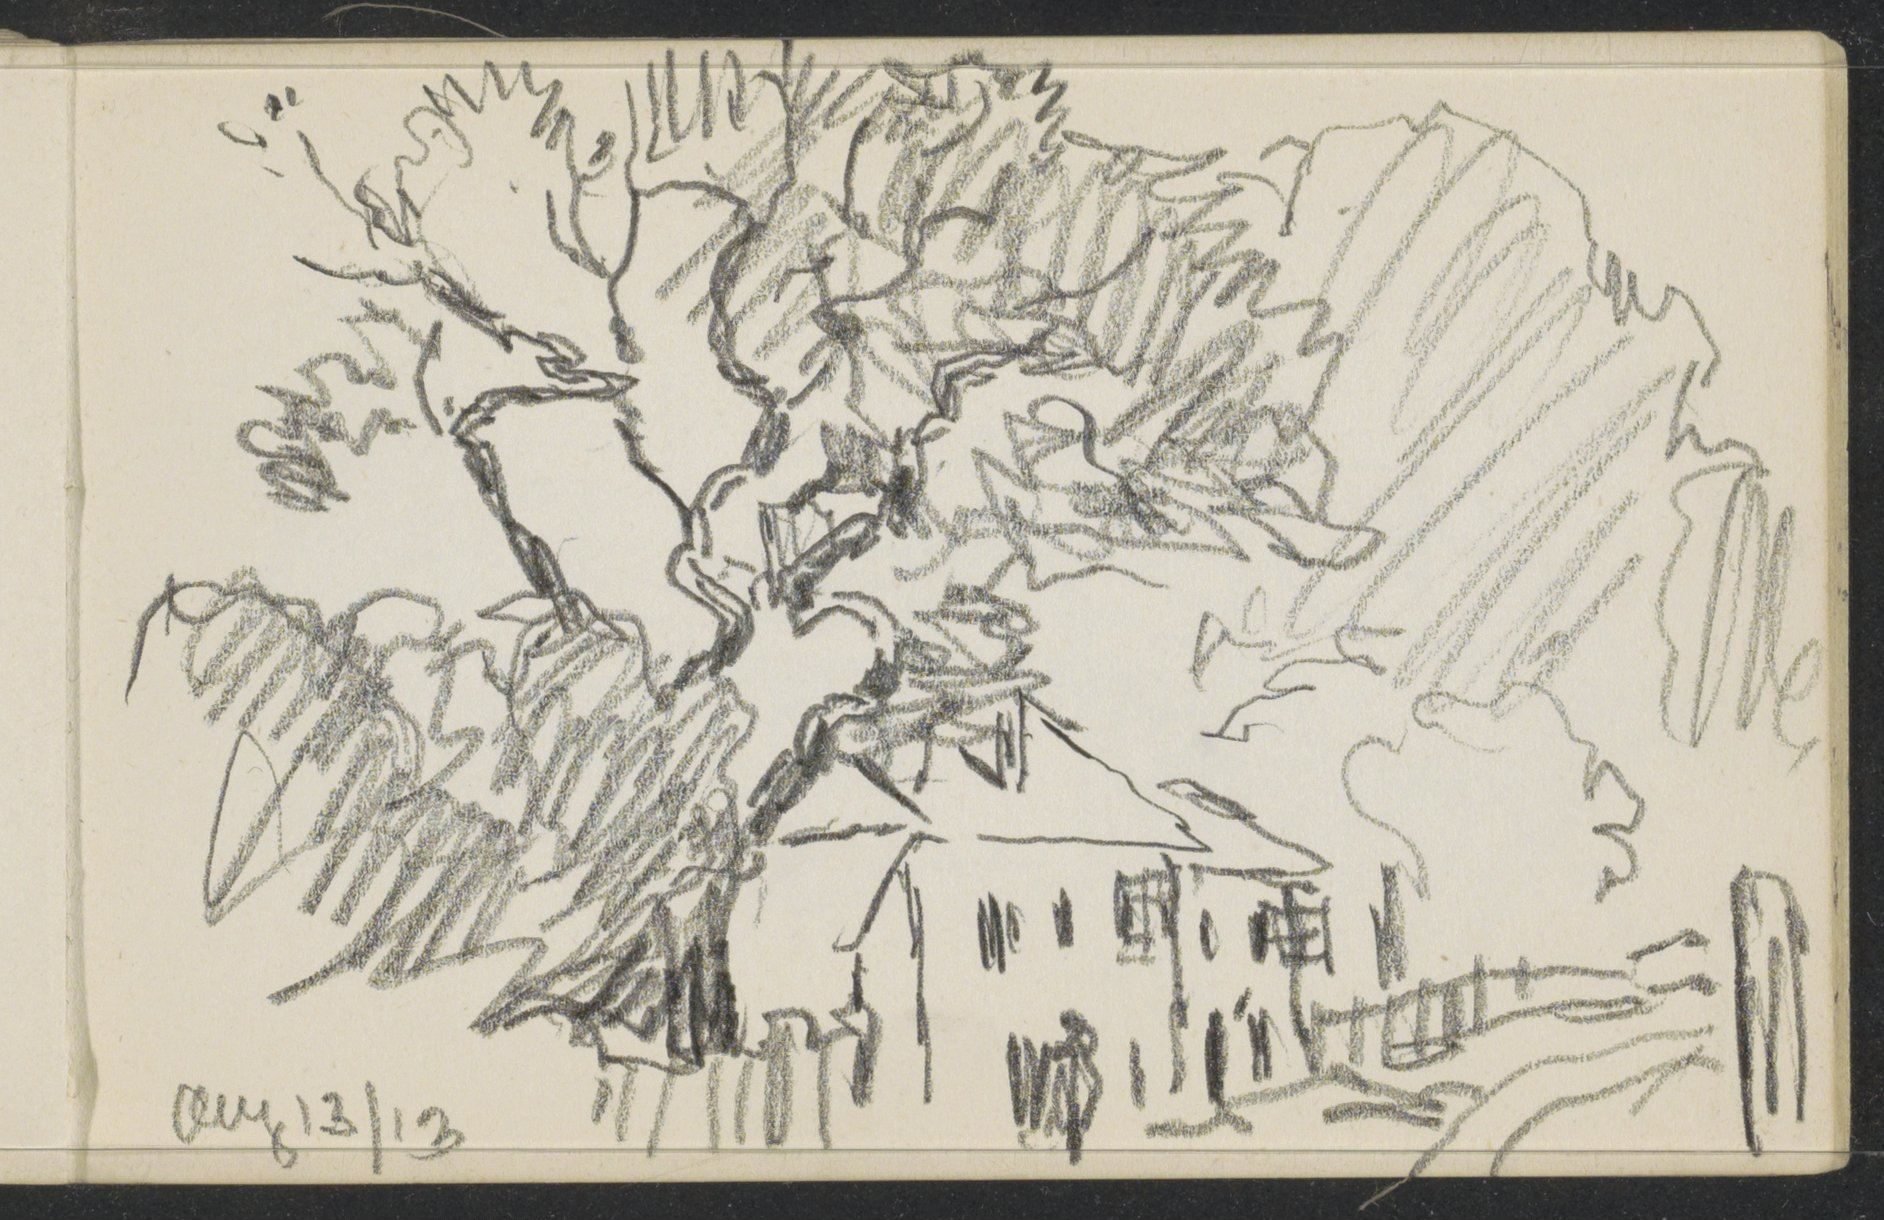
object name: sketchbook leaf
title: Huizen bij een brug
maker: alexander shilling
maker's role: draughtsman, print maker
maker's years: 1859-1937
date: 1908-1913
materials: paper, pencil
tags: city-view, and landscape with man-made constructions, bridge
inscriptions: date: ‘aug 13/13’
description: Mogelijk bij Langham Mill of Dedham. Blad 26 recto uit een schetsboek met 30 bladen.